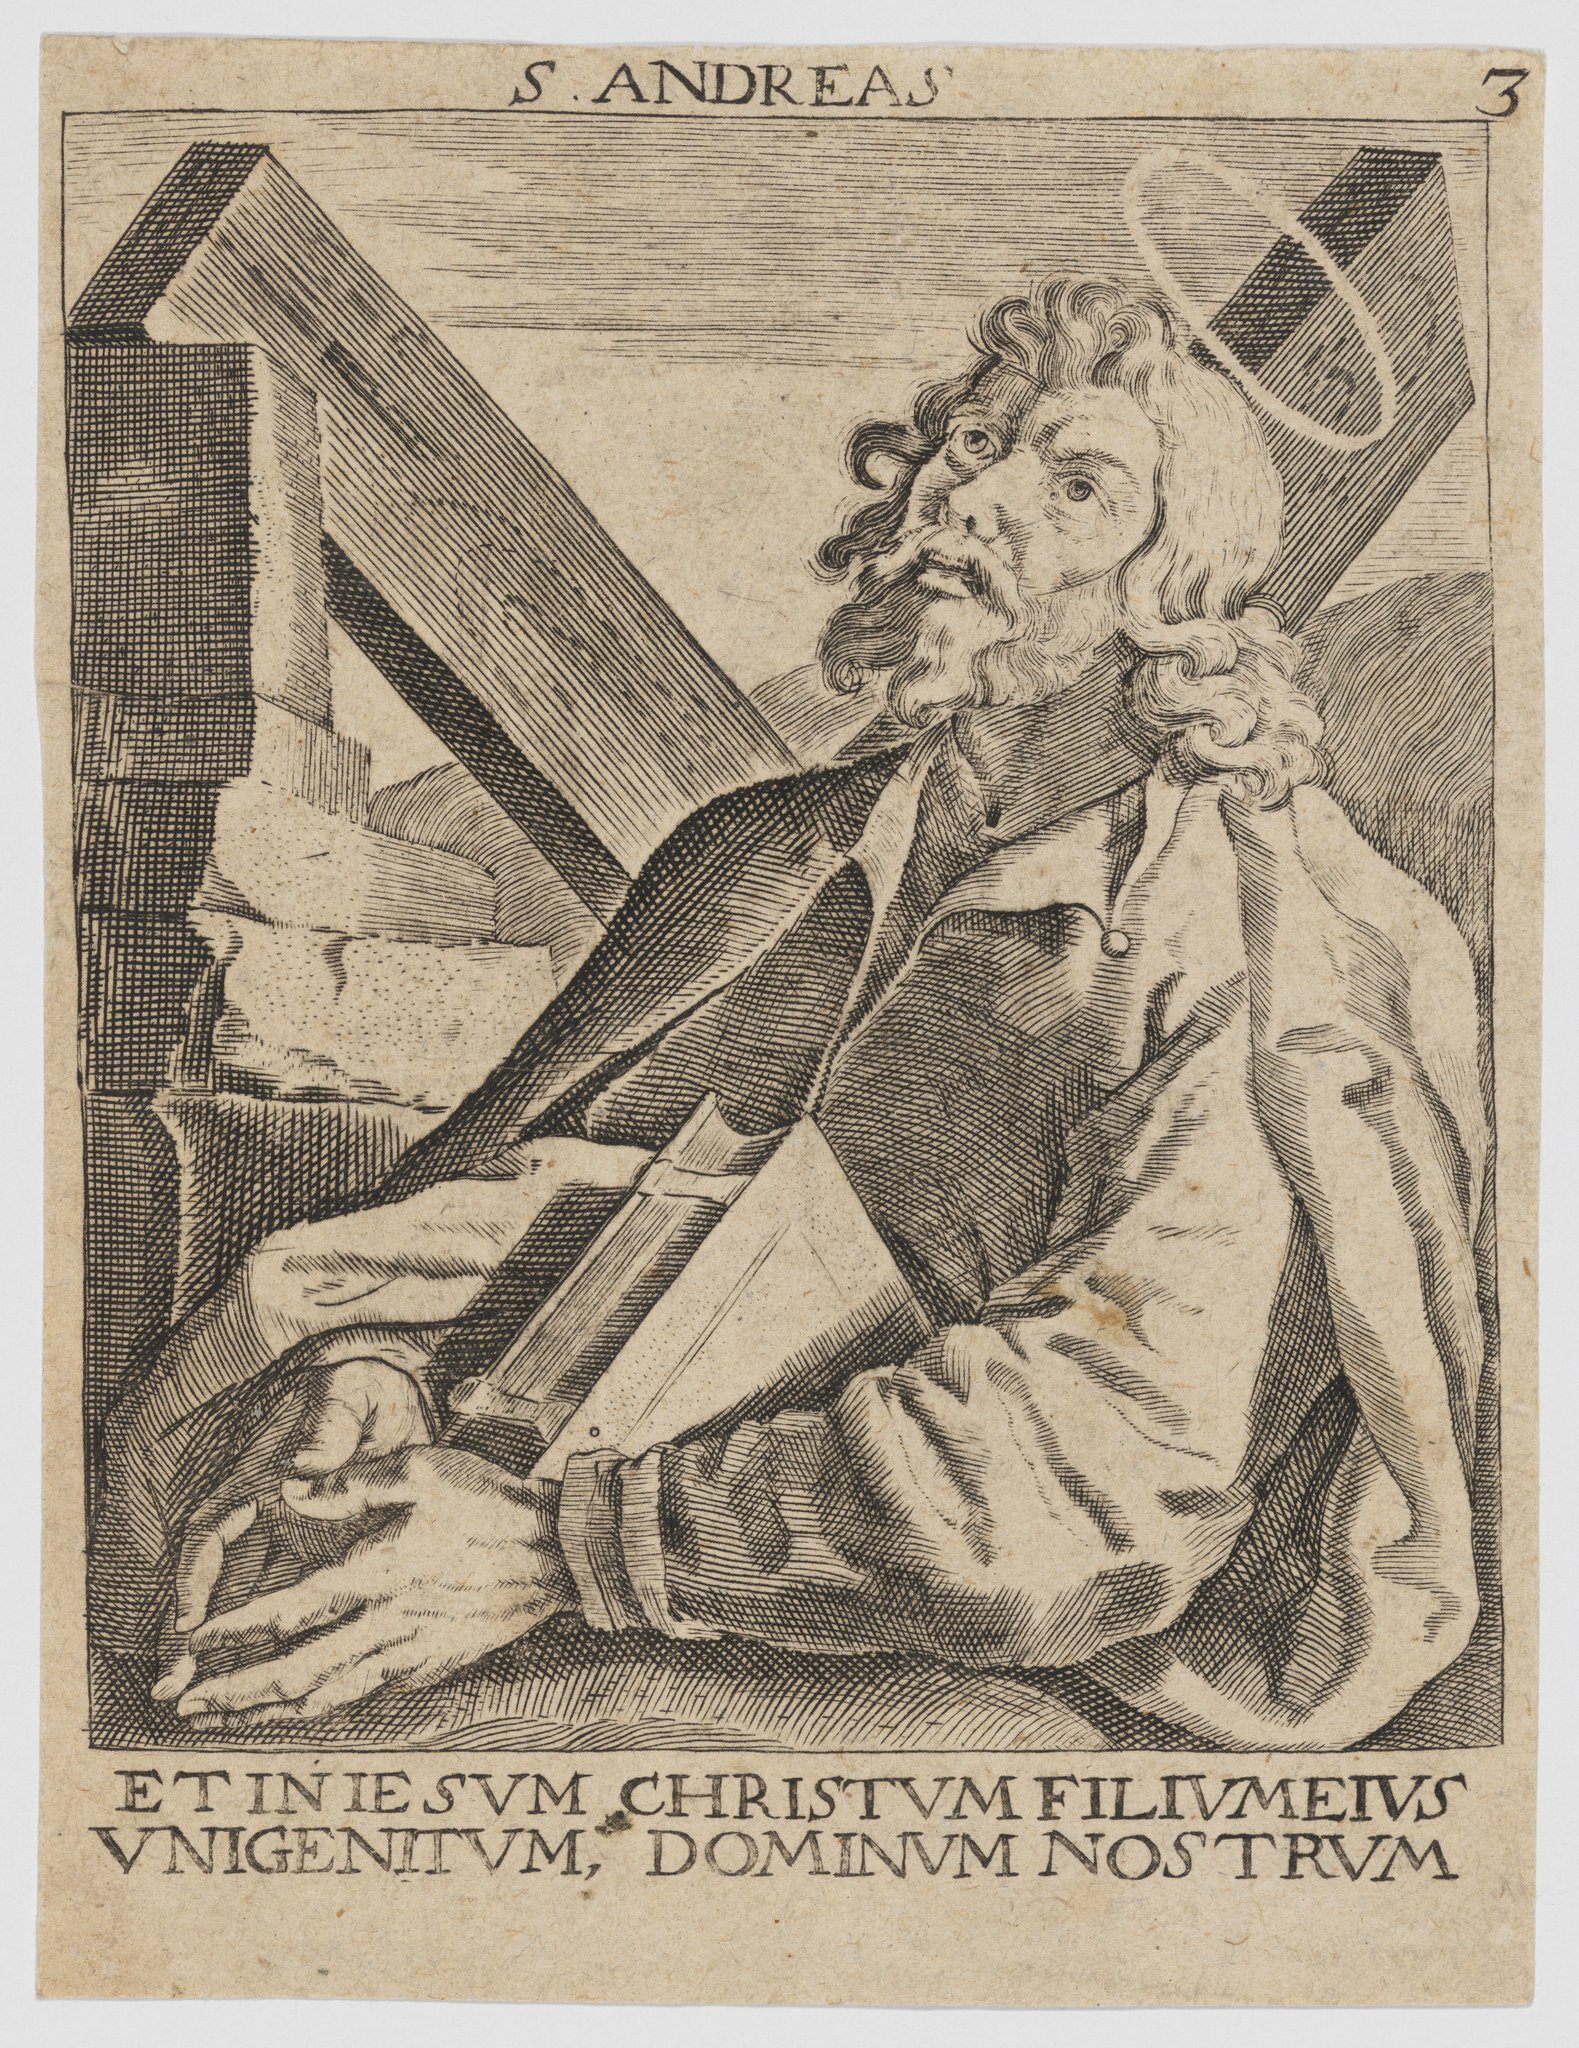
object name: print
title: St. Andrew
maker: anonymous, netherlandish, 16th century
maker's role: artist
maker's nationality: netherlandish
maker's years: 1500-1600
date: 1594-1640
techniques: engraving